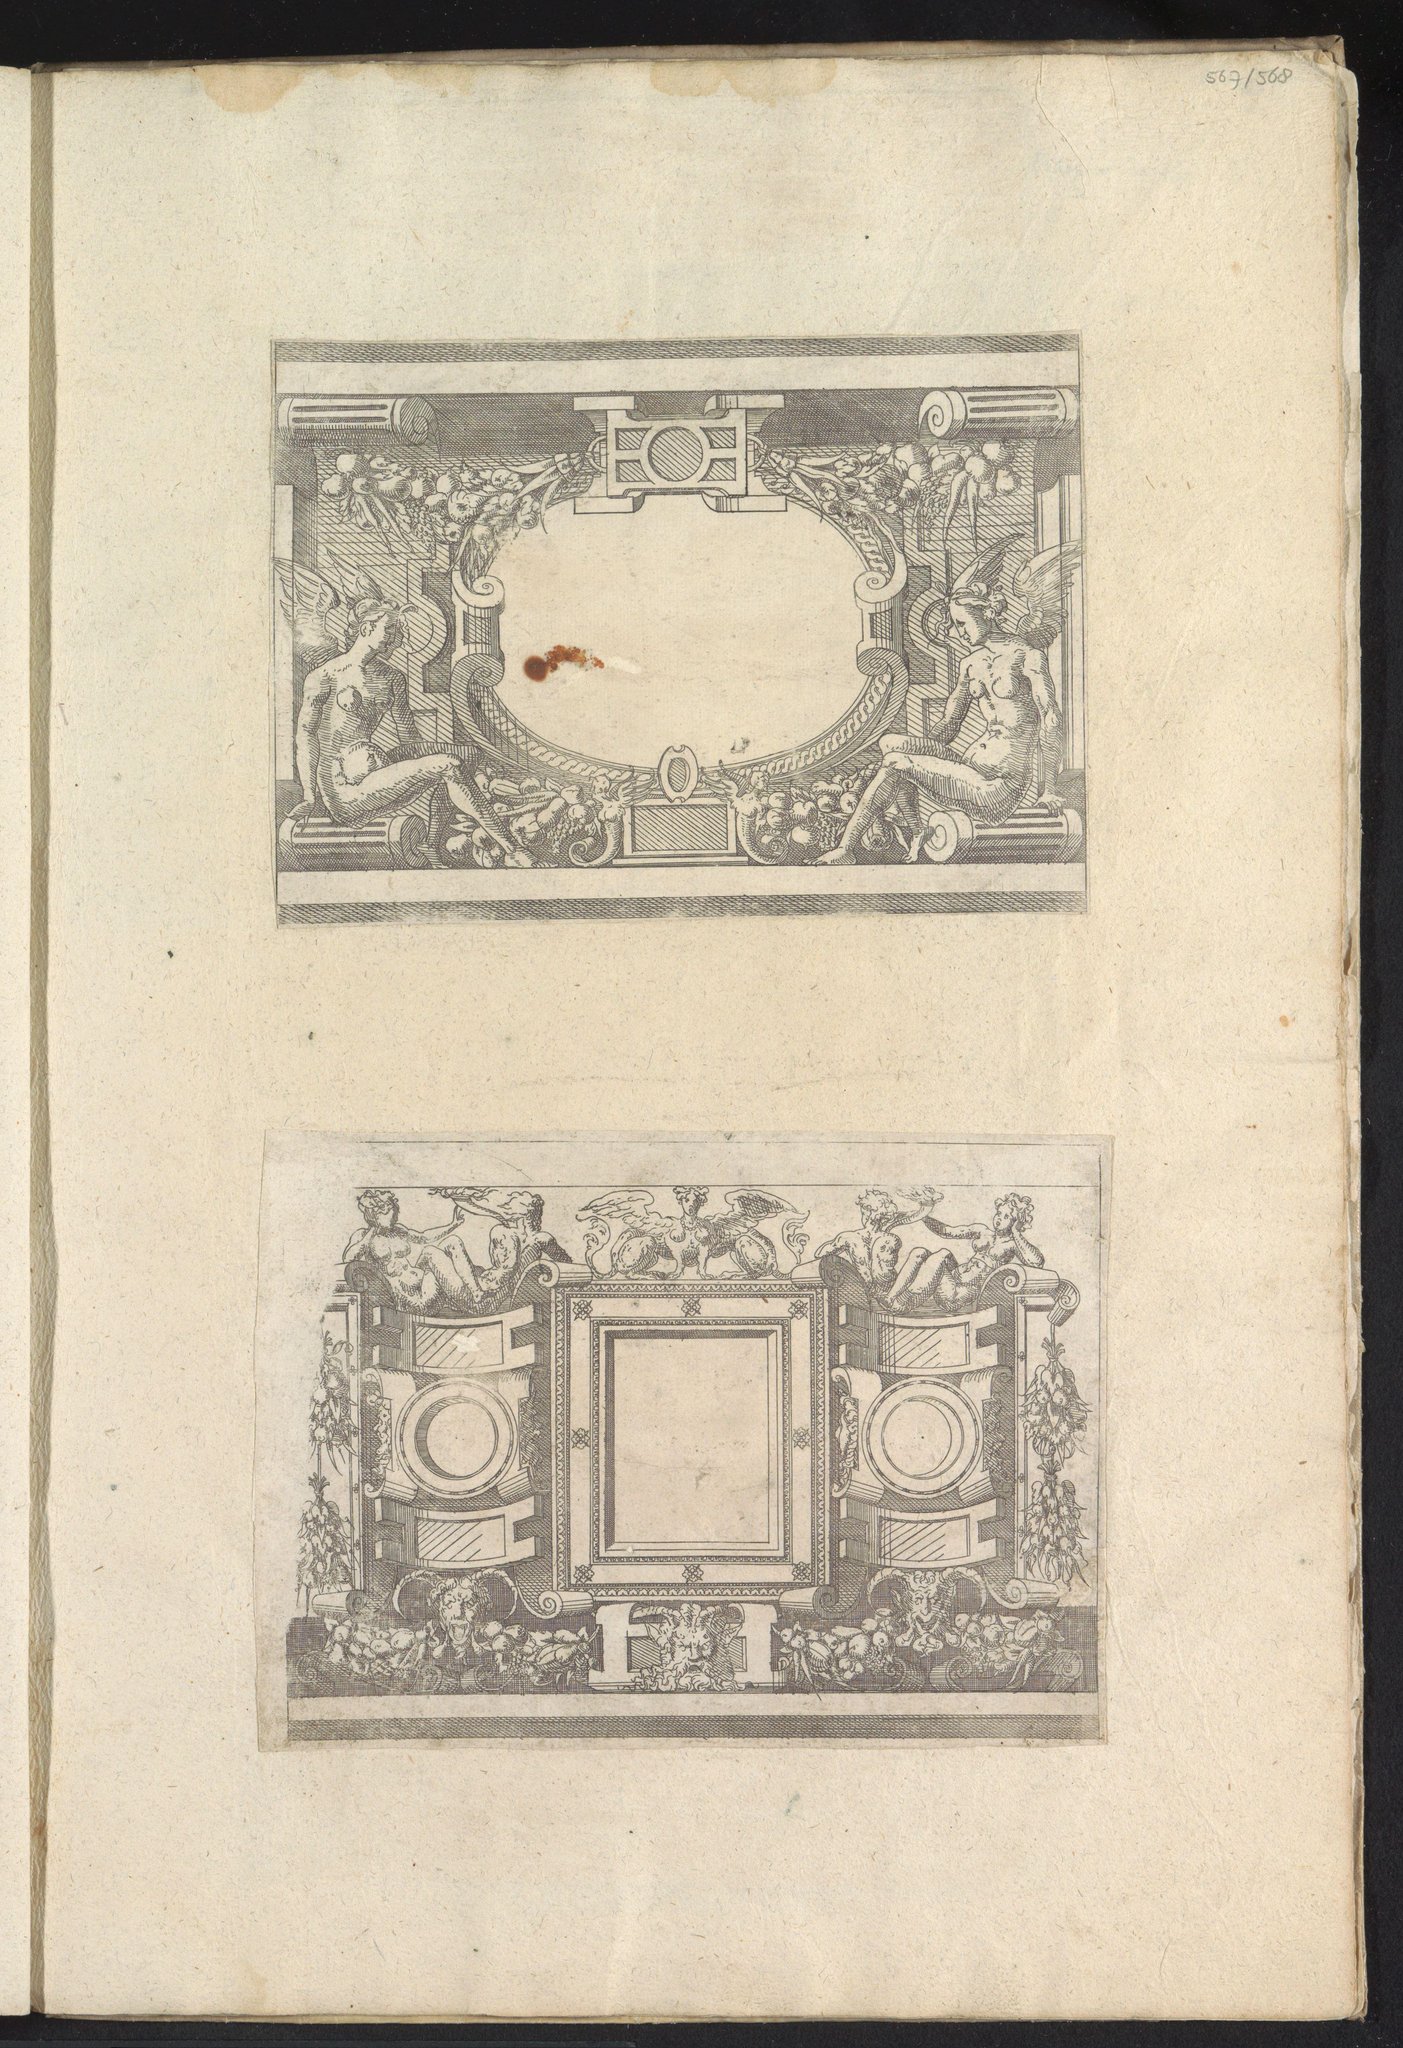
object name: ornament print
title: Albumblad met twee prenten van cartouches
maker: Anonymous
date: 1500-1599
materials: paper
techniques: etching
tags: ornament ~ cartouche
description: Albumblad met twee uitgeknipte prenten met ornamentele cartouches.